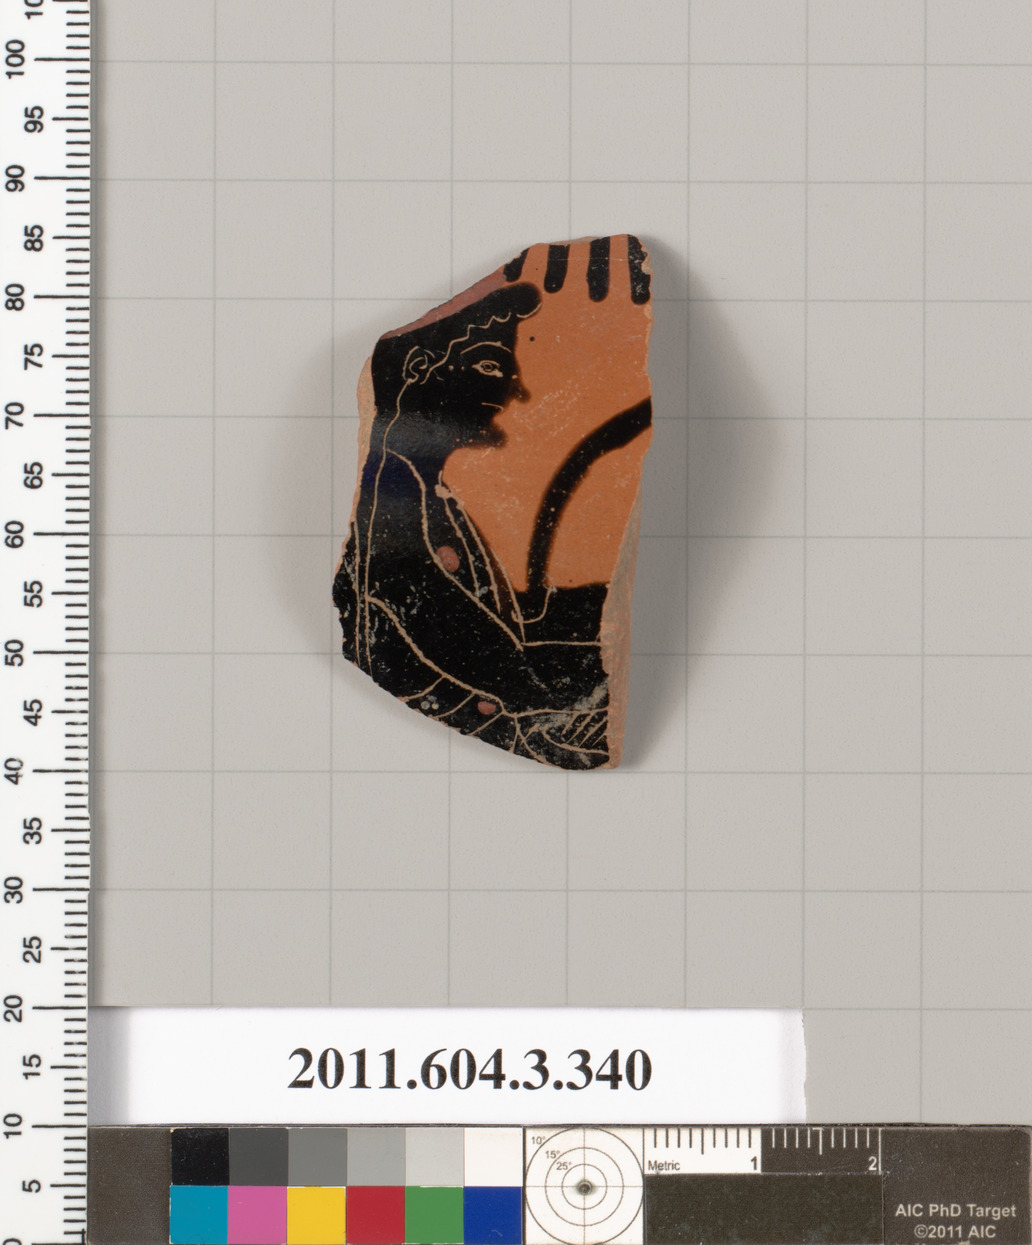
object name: neck amphora fragment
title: Terracotta fragment of a neck-amphora (jar)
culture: greek, attic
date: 534-468 BCE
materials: terracotta